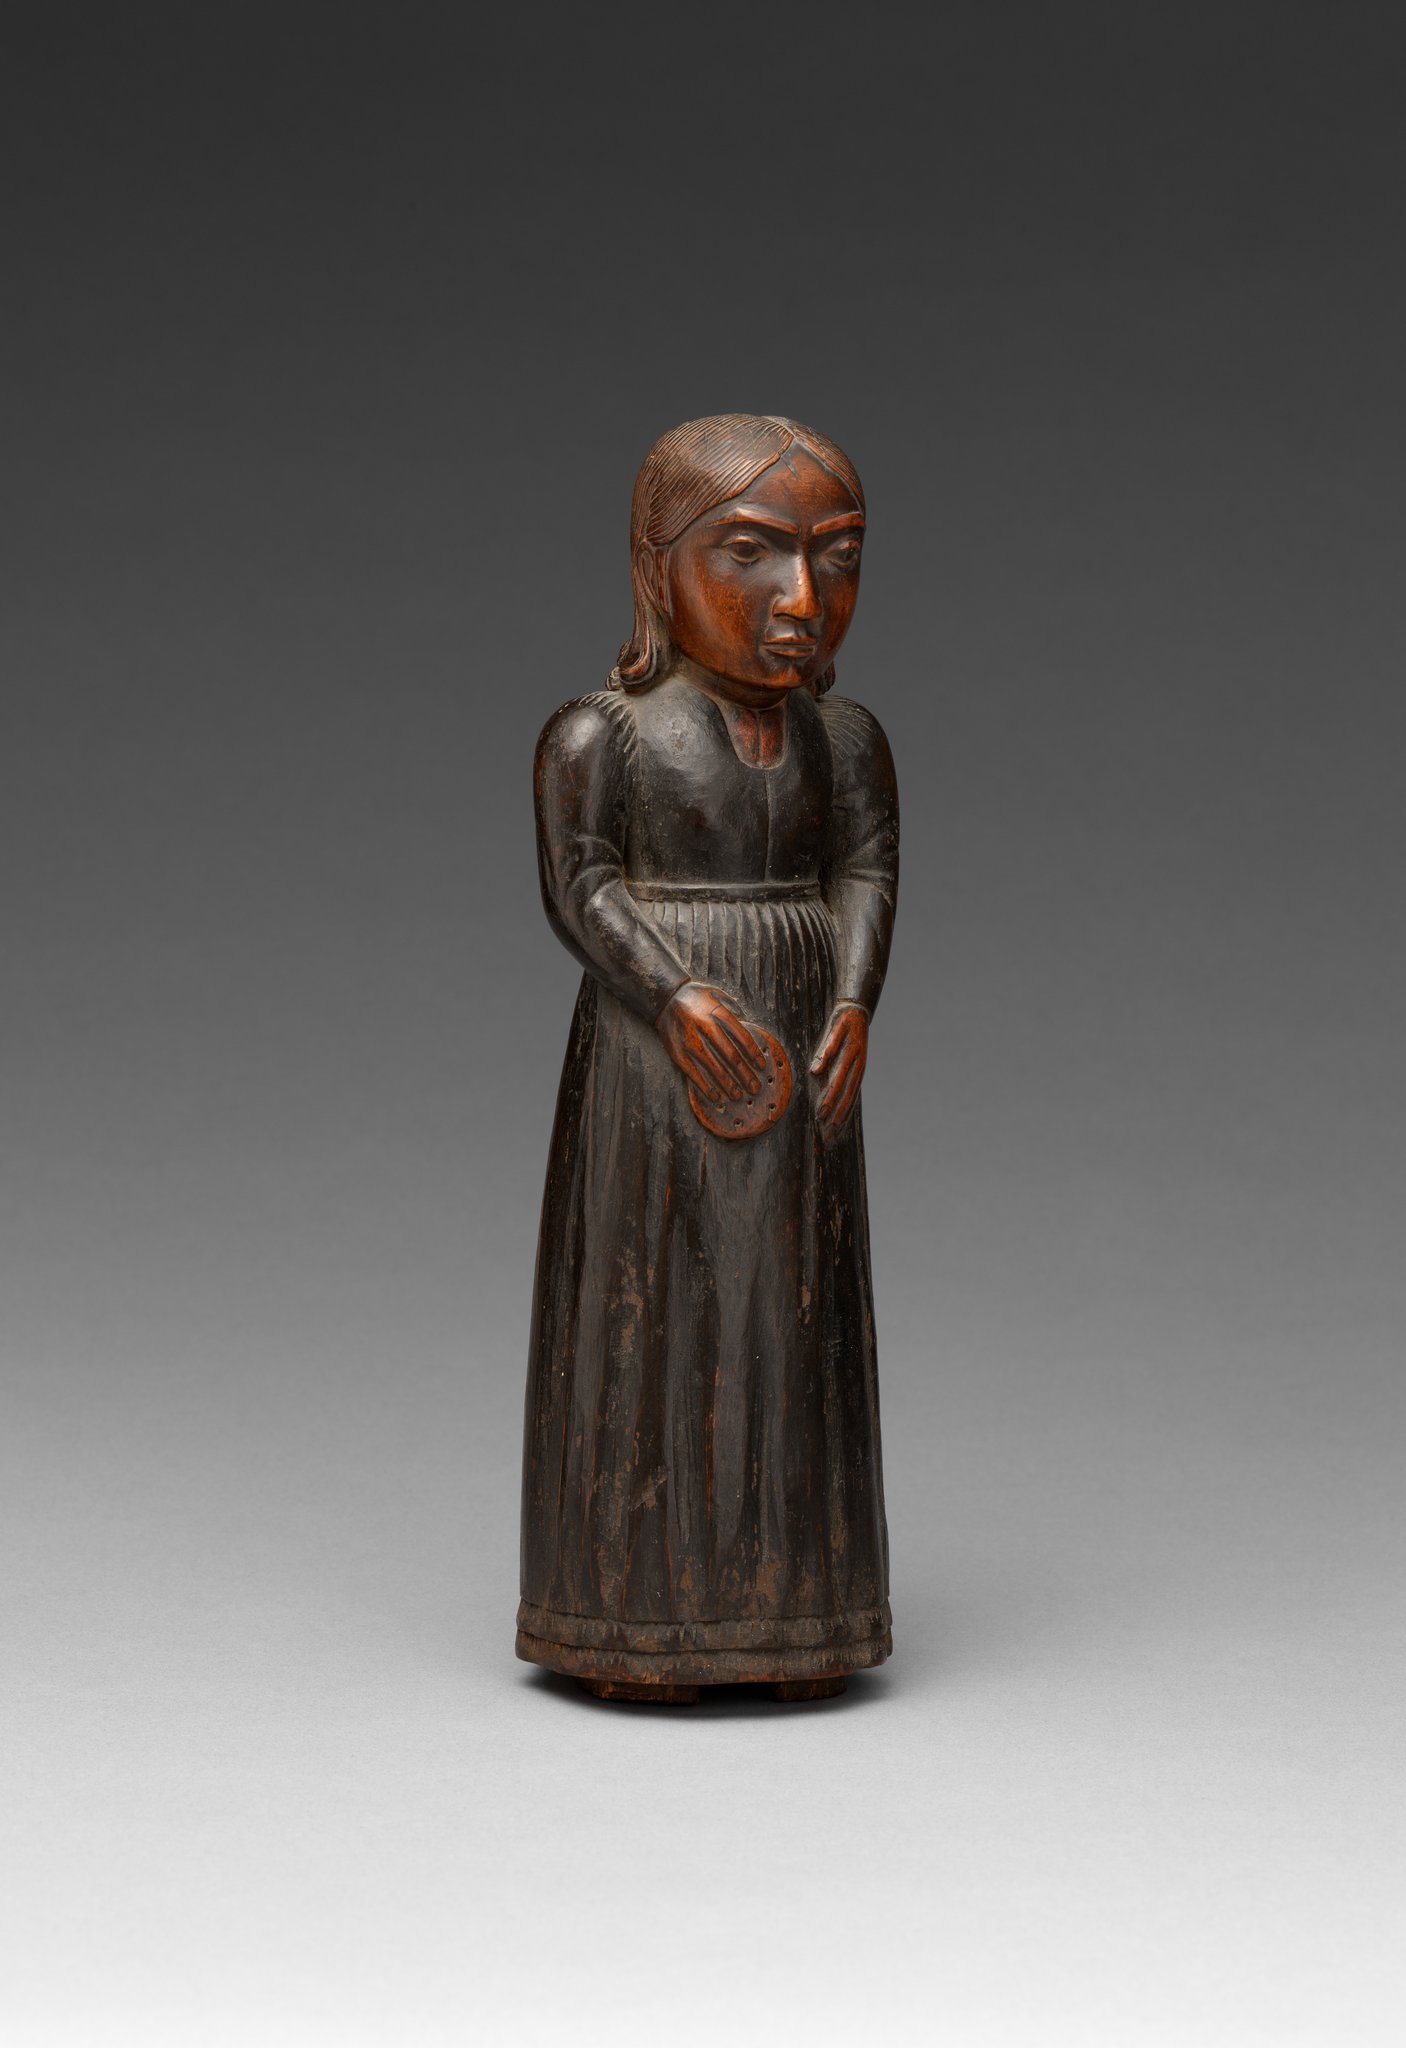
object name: portrait figure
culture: native american, haida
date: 1840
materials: pigment, wood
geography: canada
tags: women